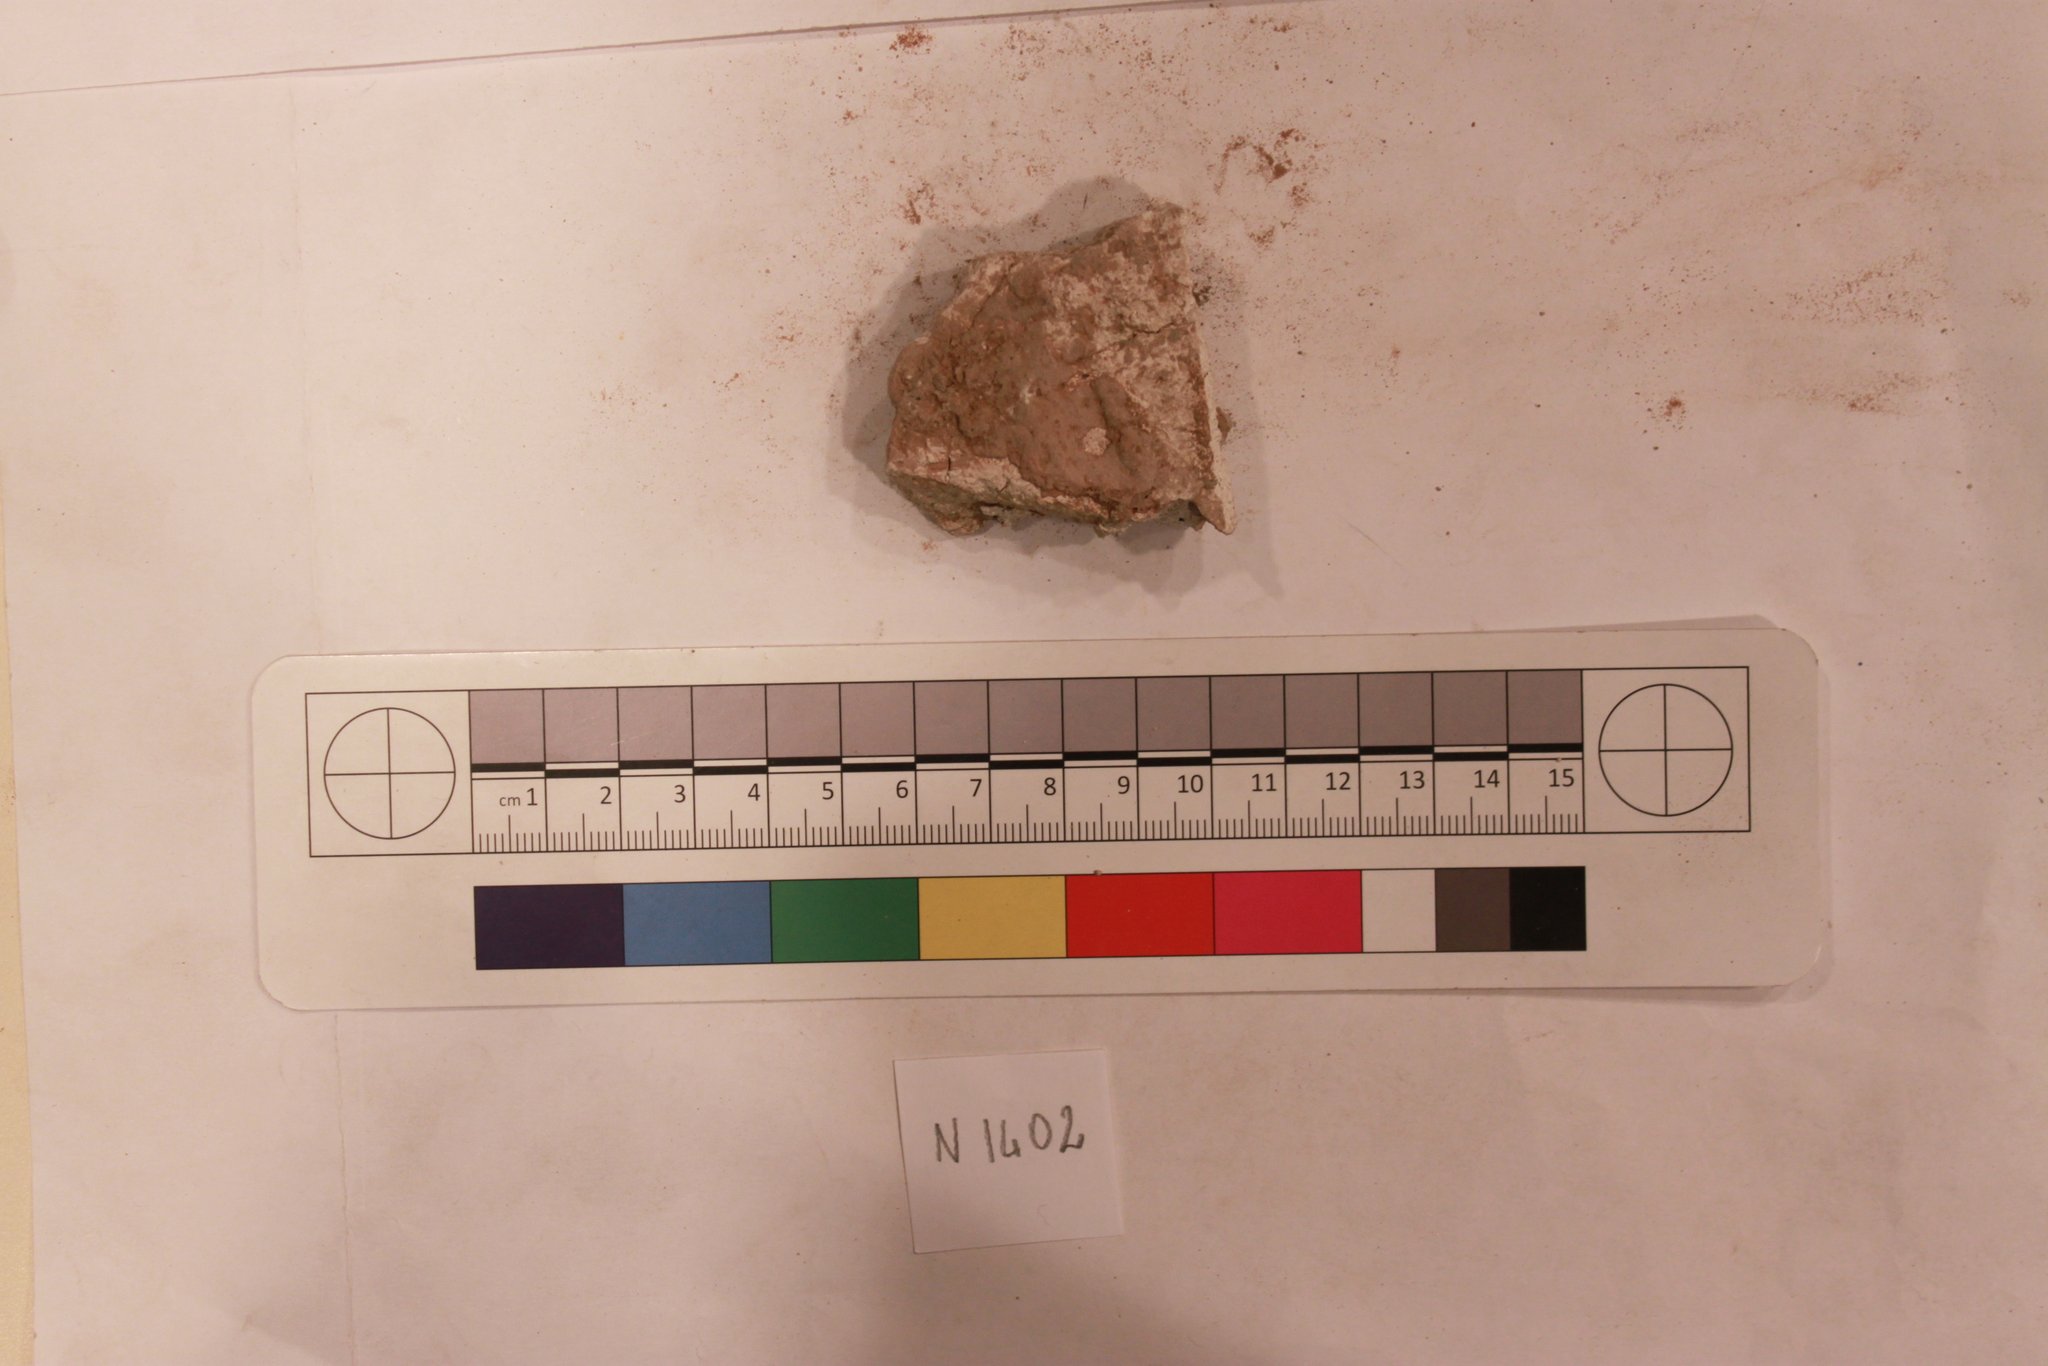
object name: fragment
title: Stucco Fragment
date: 701-1200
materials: plaster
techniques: carving, painting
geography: iran